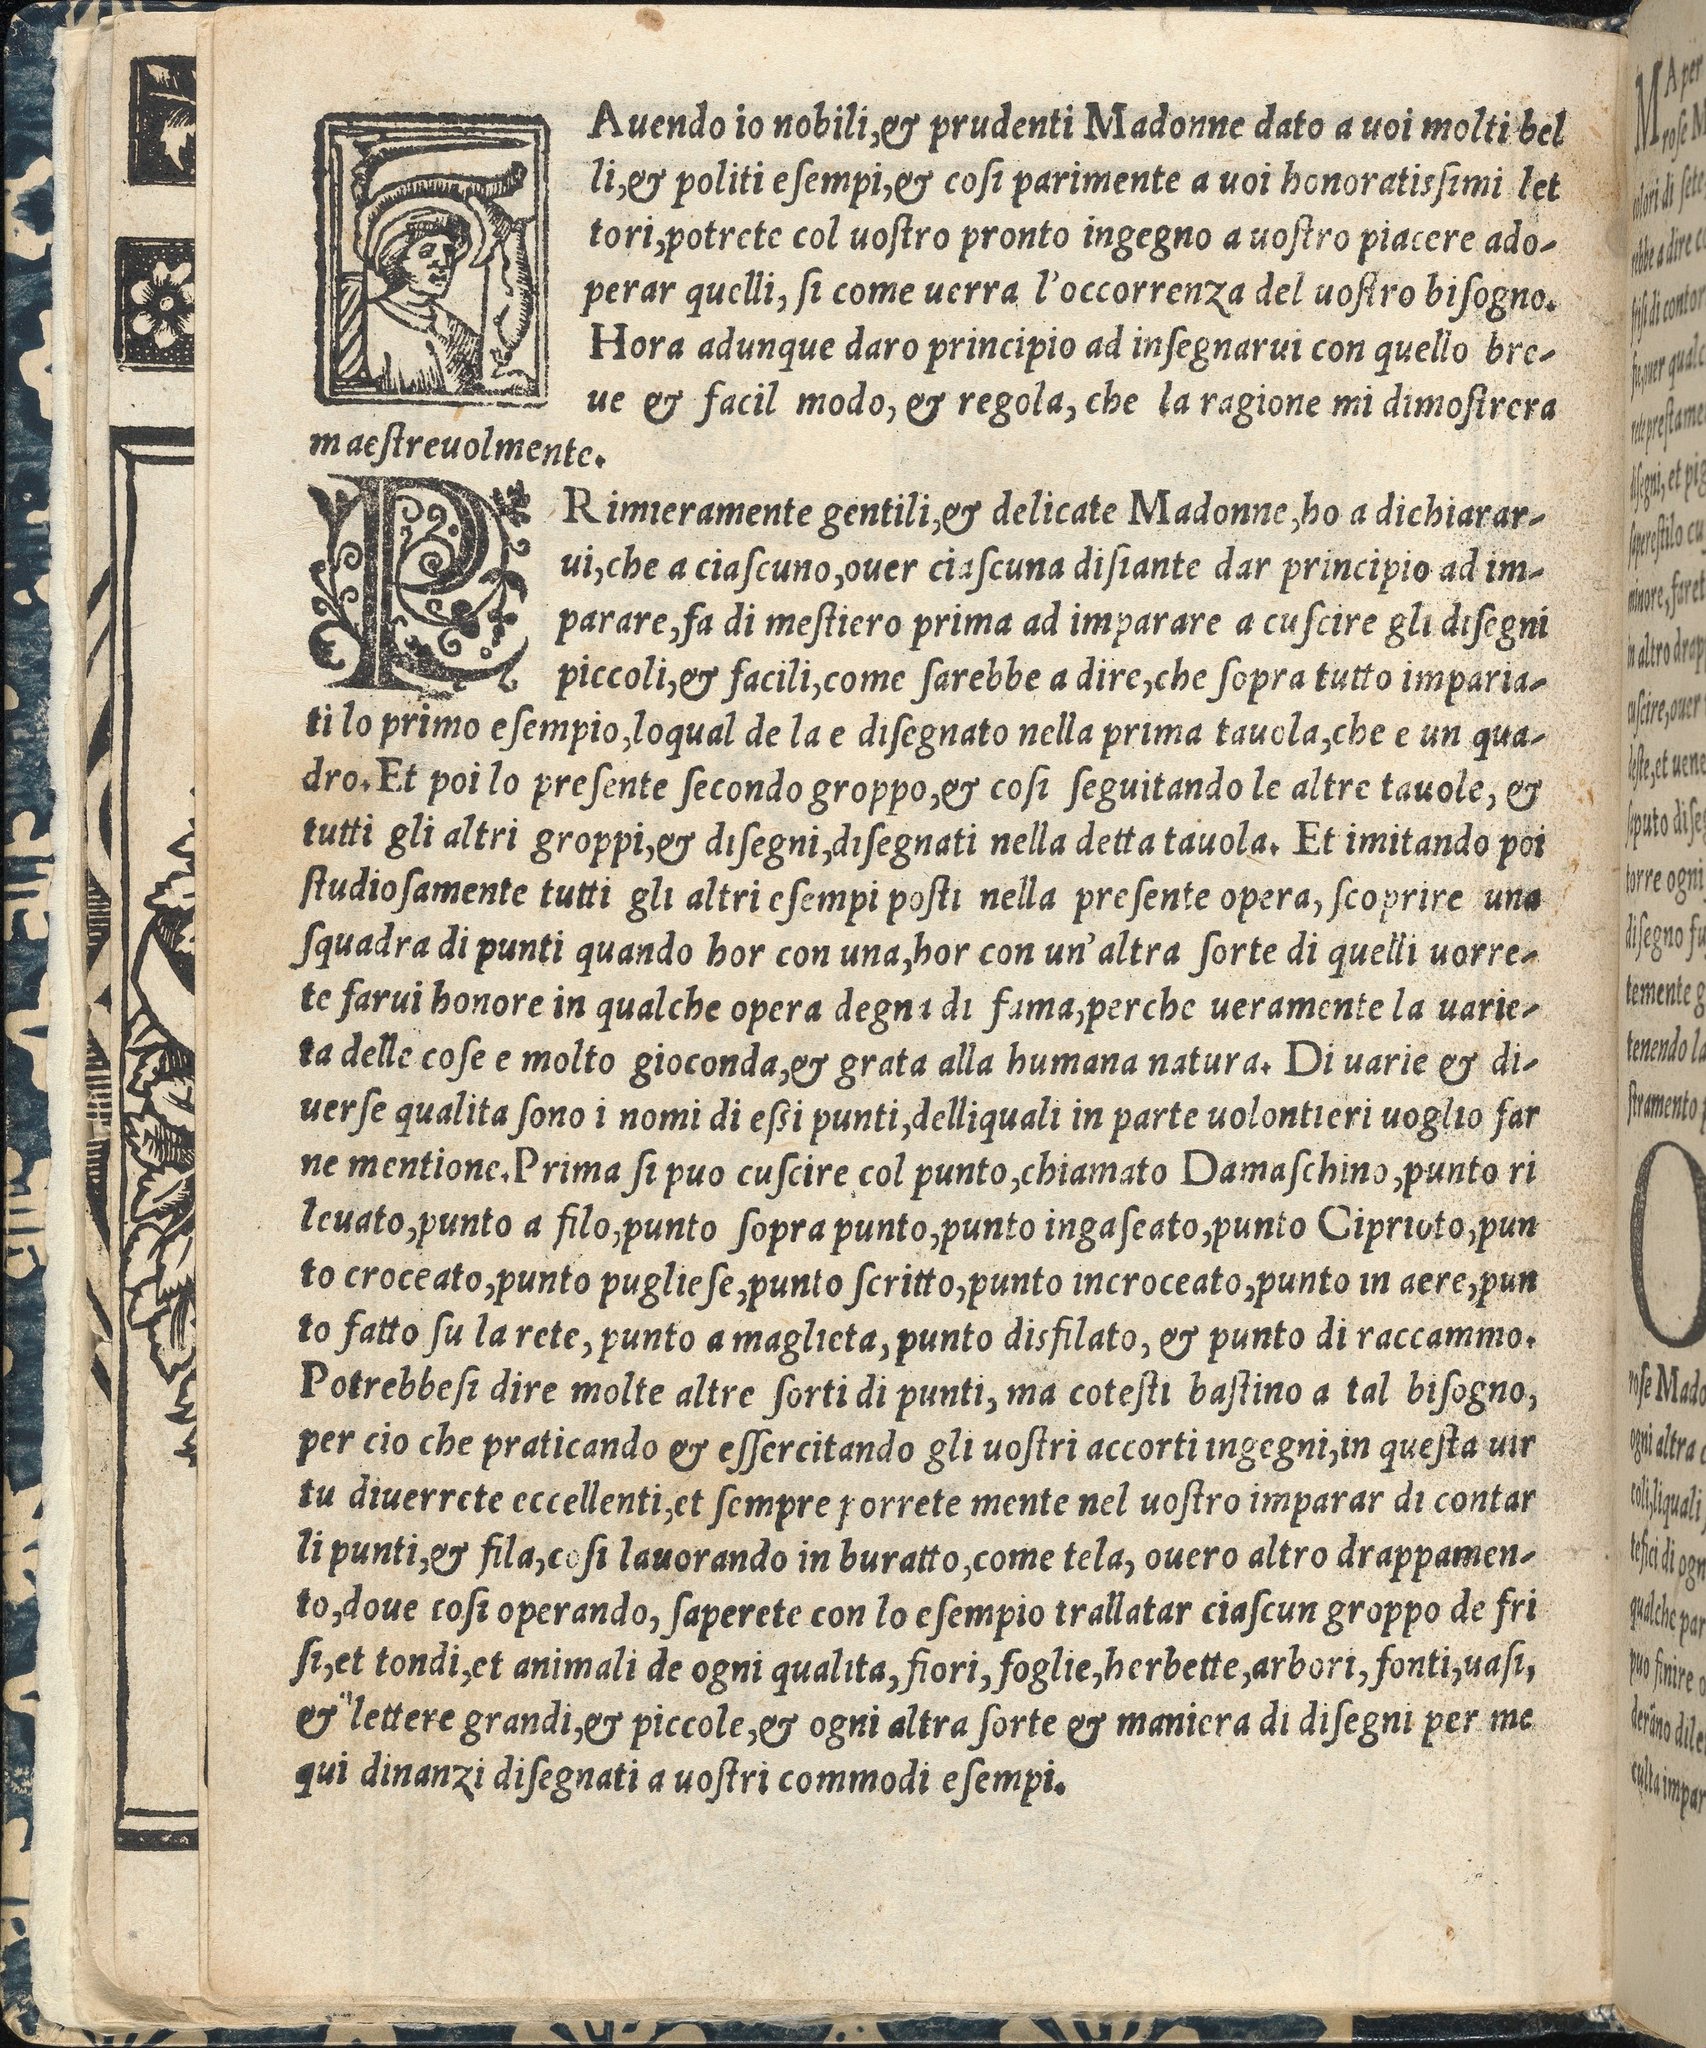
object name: book print ornament architecture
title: Essempio di recammi, page 25 (verso)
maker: giovanni antonio tagliente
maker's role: author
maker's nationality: italian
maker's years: 1465-1528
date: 1530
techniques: woodcut